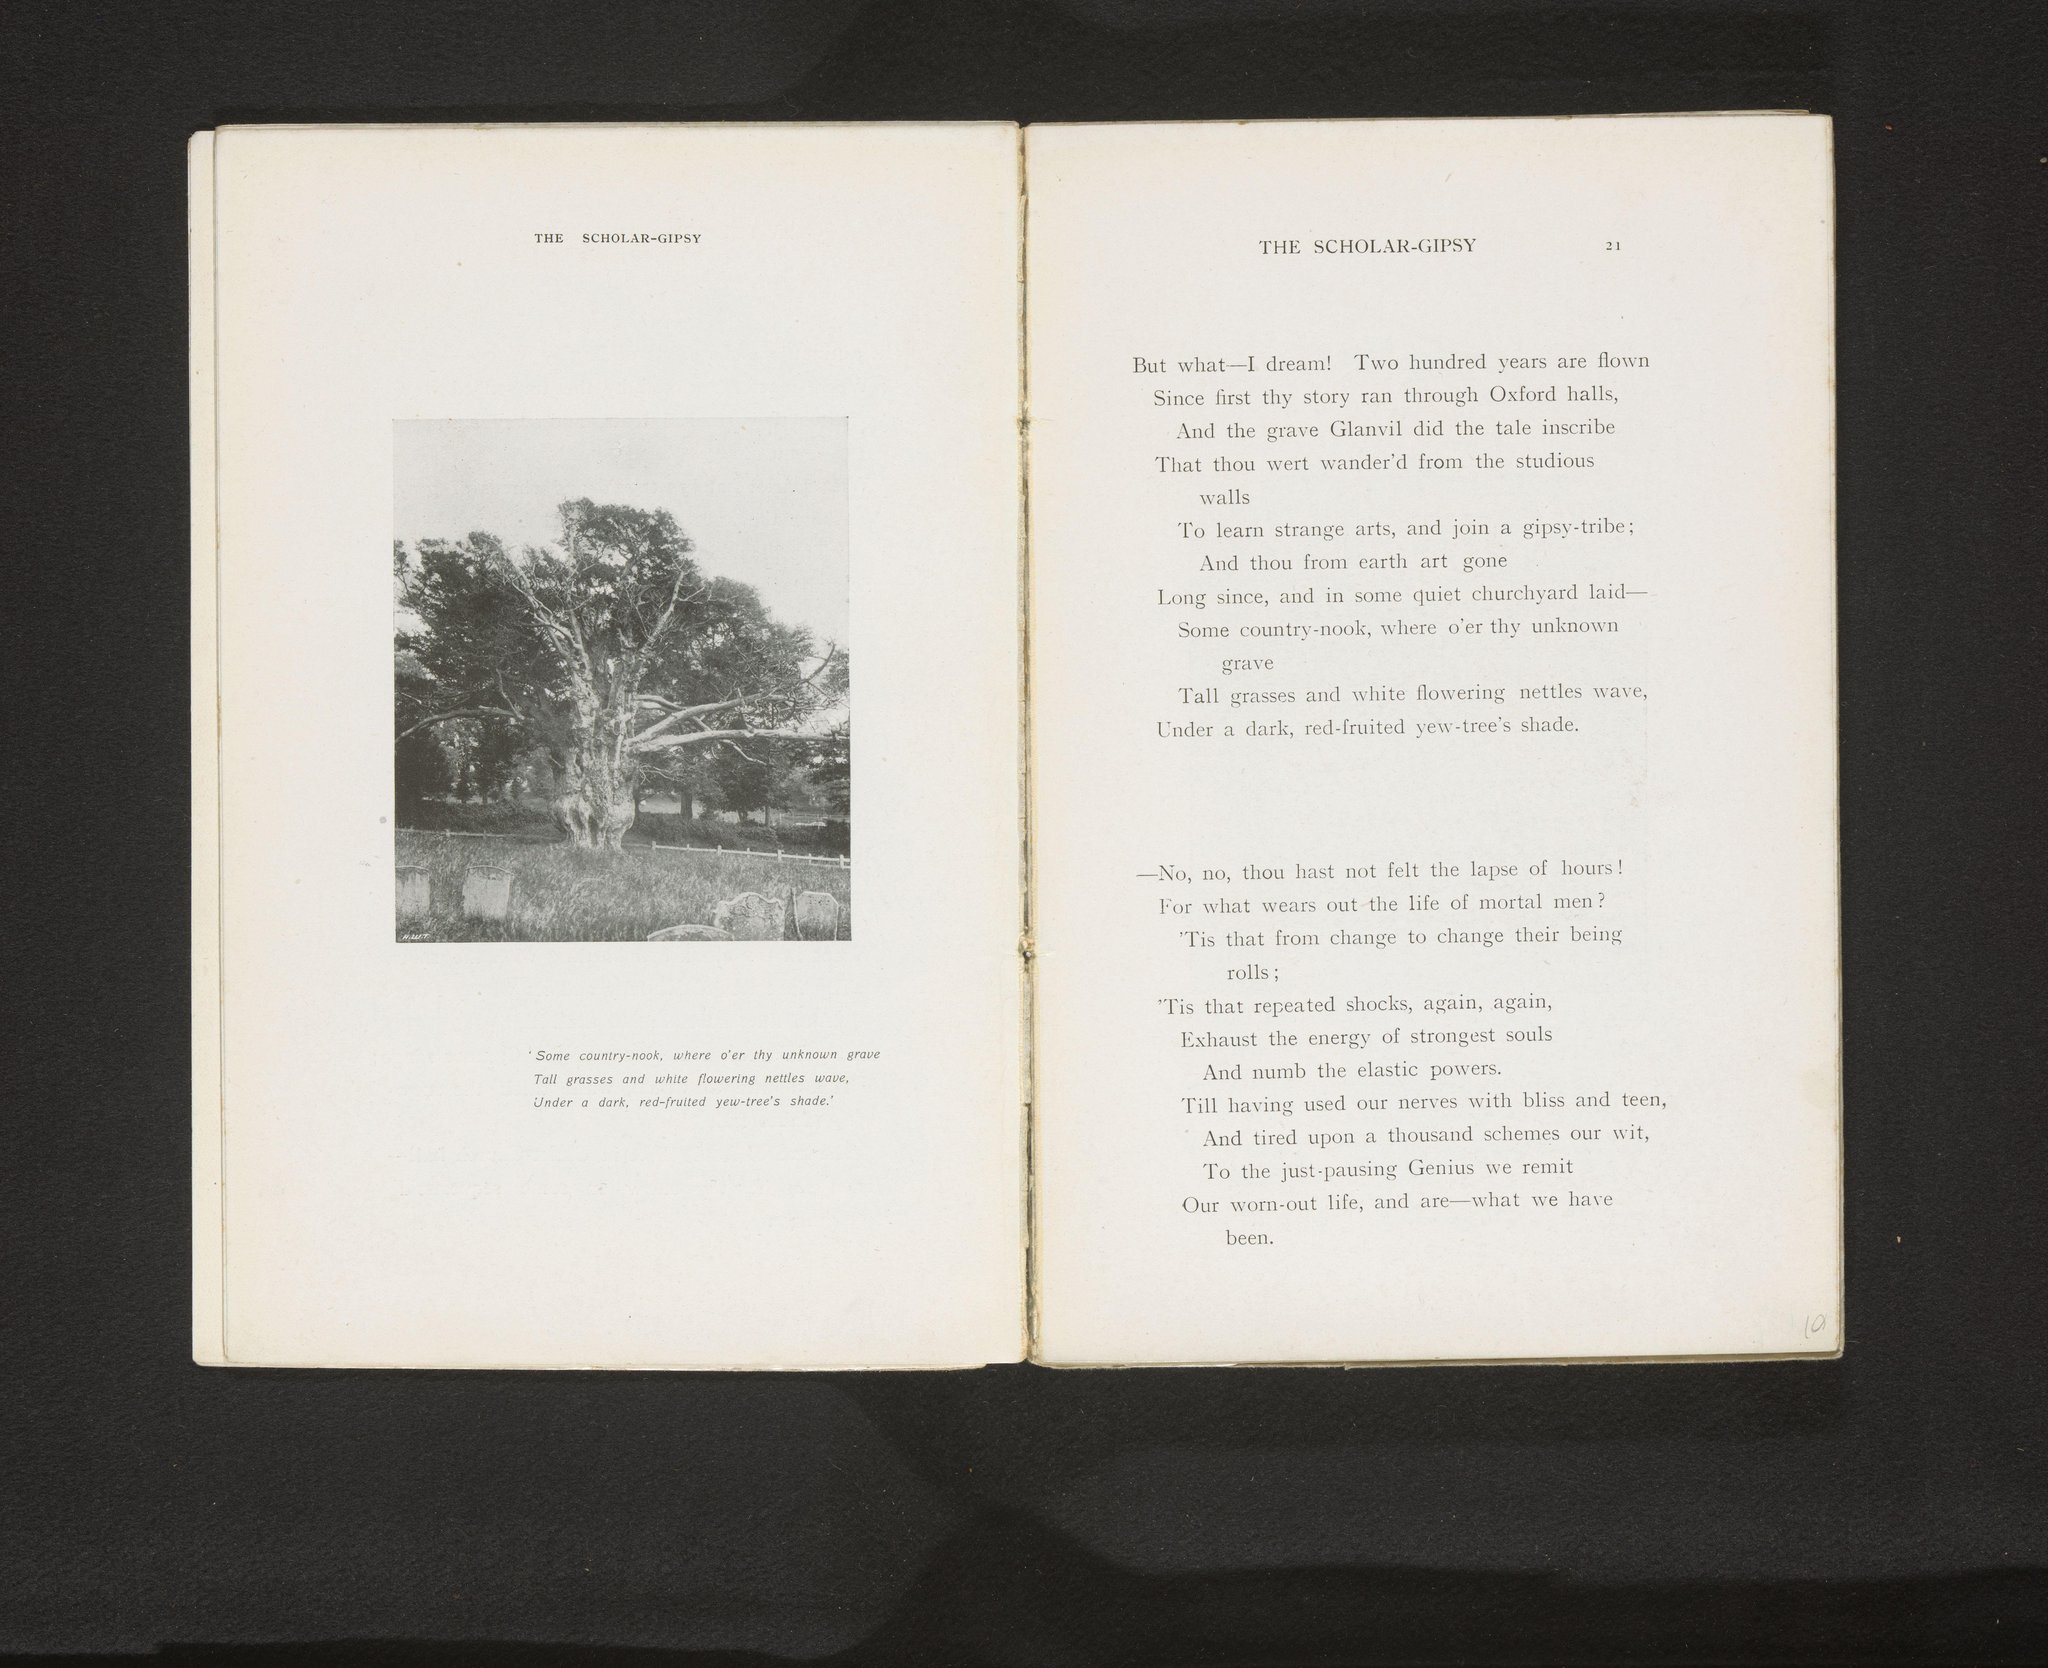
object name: page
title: Gezicht op een boom op een begraafplaats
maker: henry w. taunt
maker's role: fotograaf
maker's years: 1842-1922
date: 1907-1912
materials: paper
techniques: autotype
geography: united kingdom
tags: trees, churchyard, cemetery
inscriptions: inscription: ‘'Some country-nook, (...) yew-tree's shade.'’